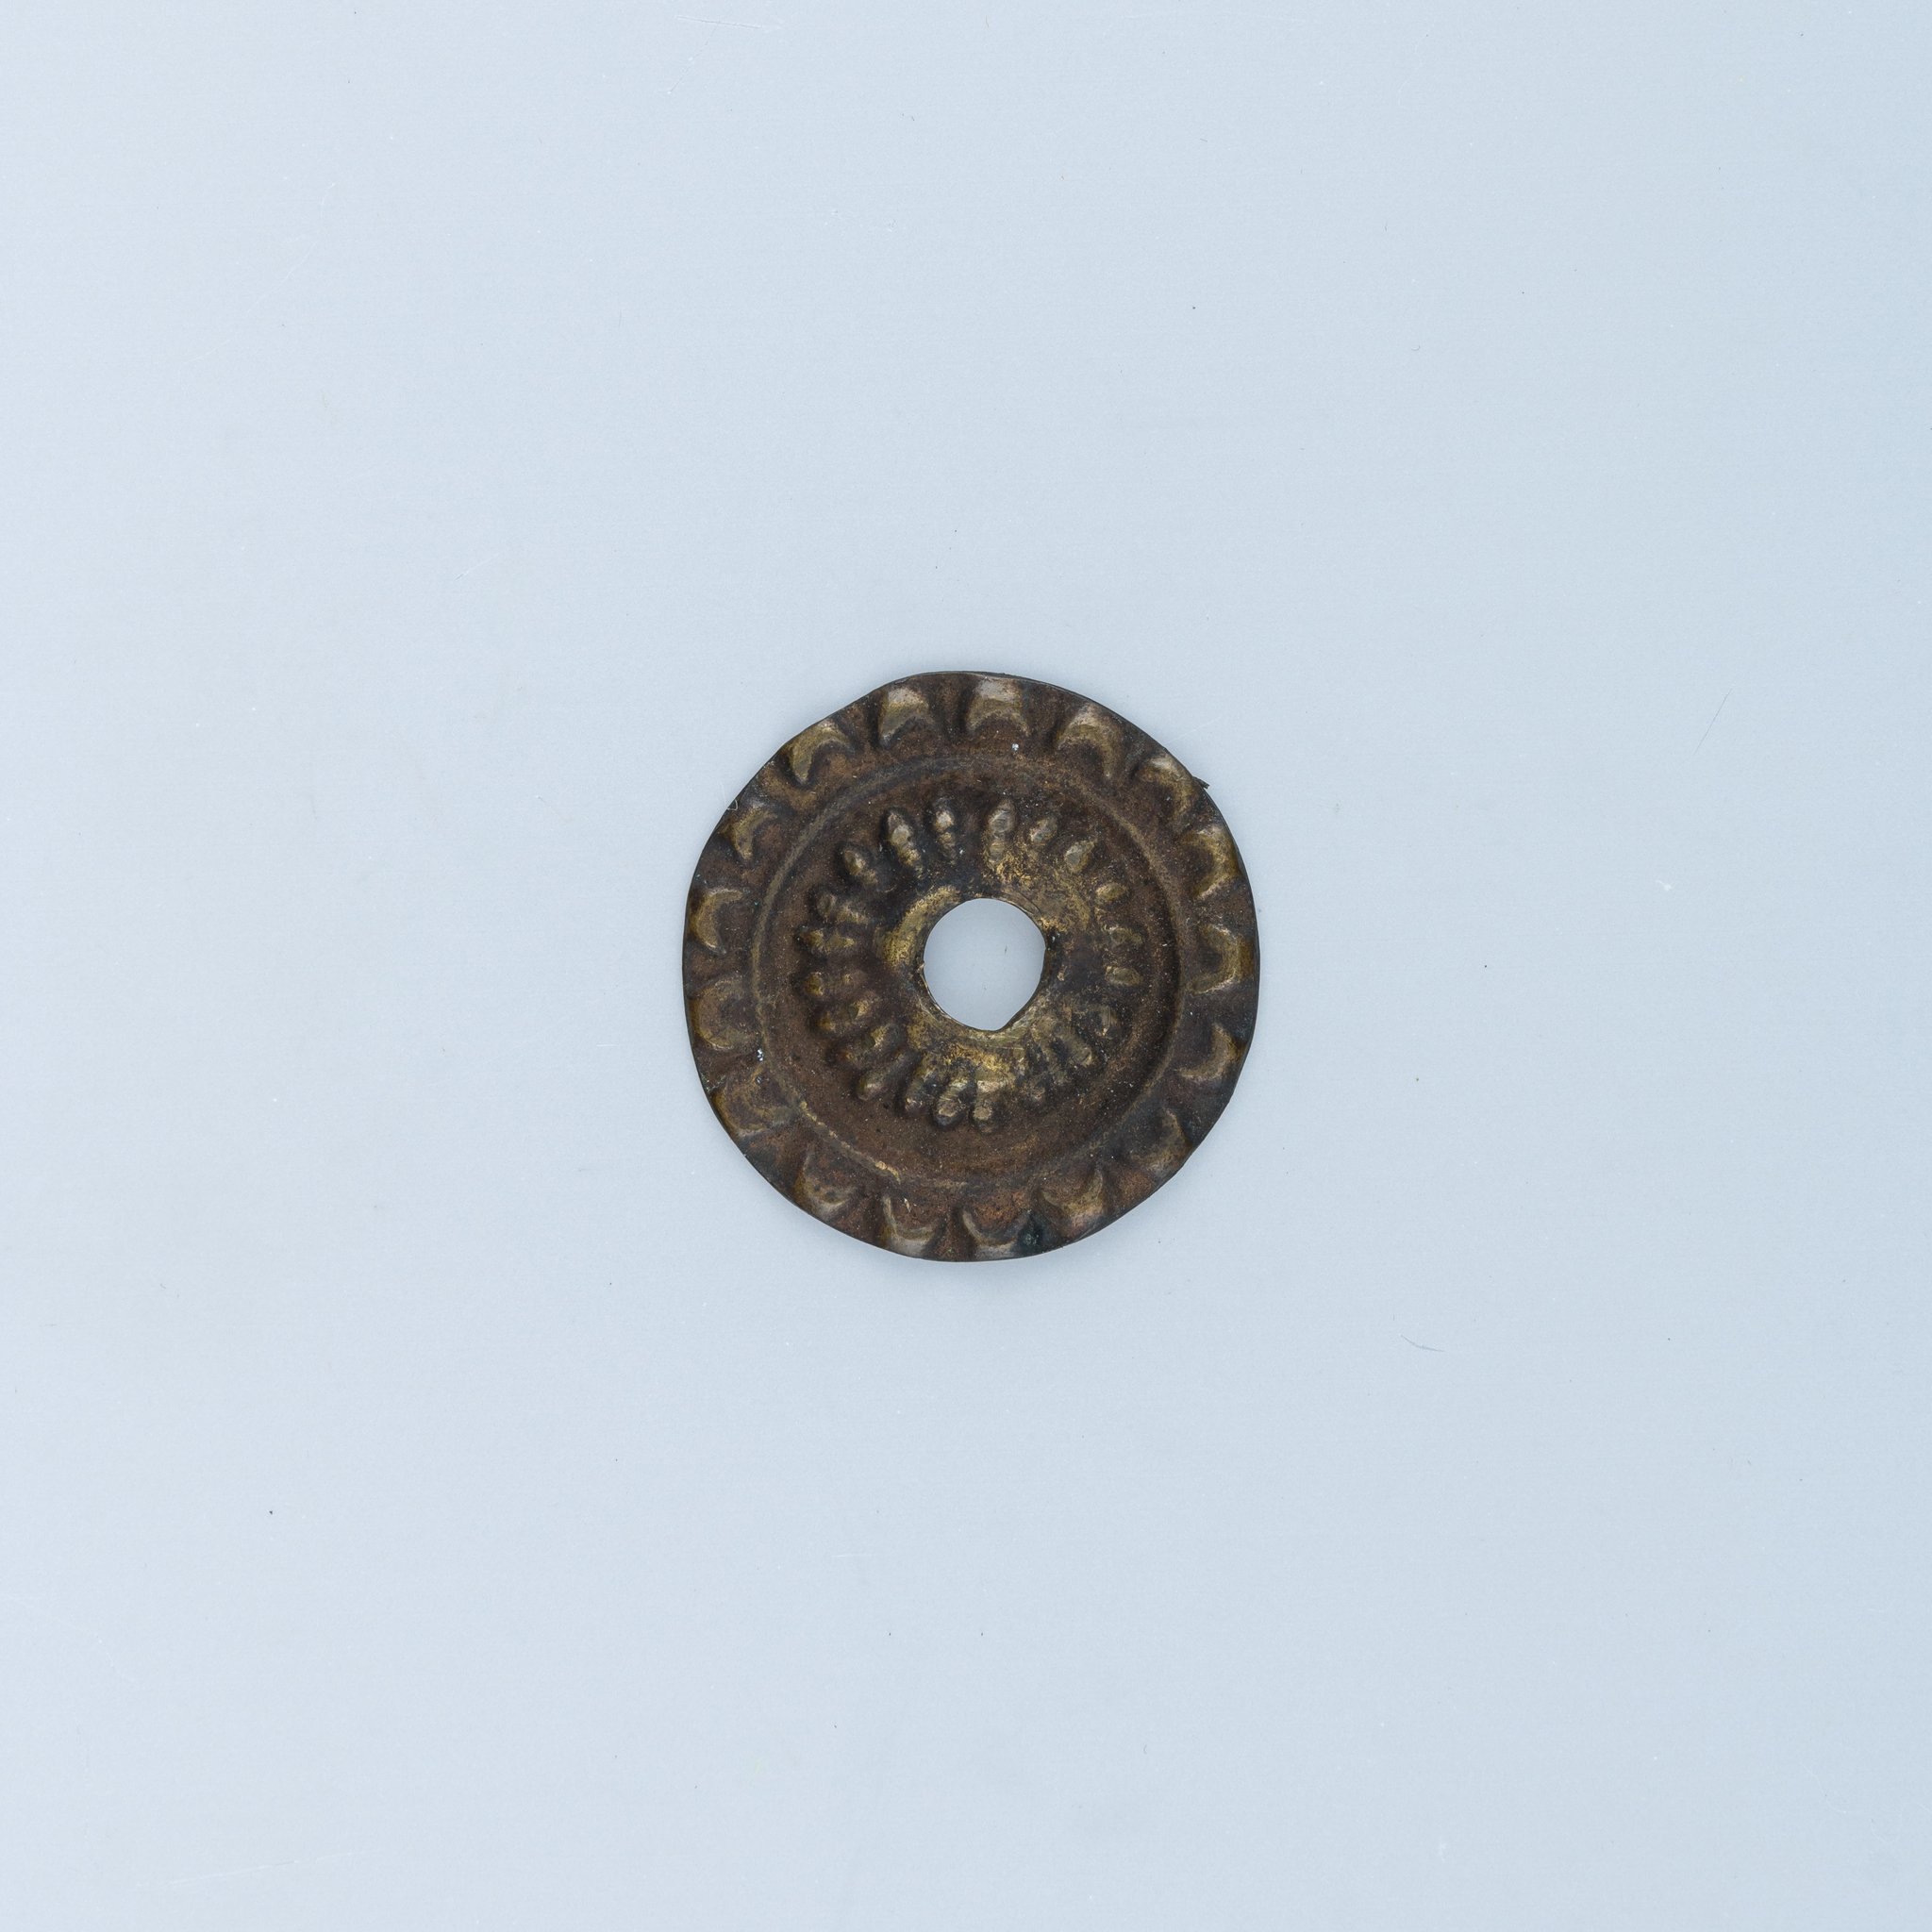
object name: rosette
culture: german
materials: brass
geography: germany